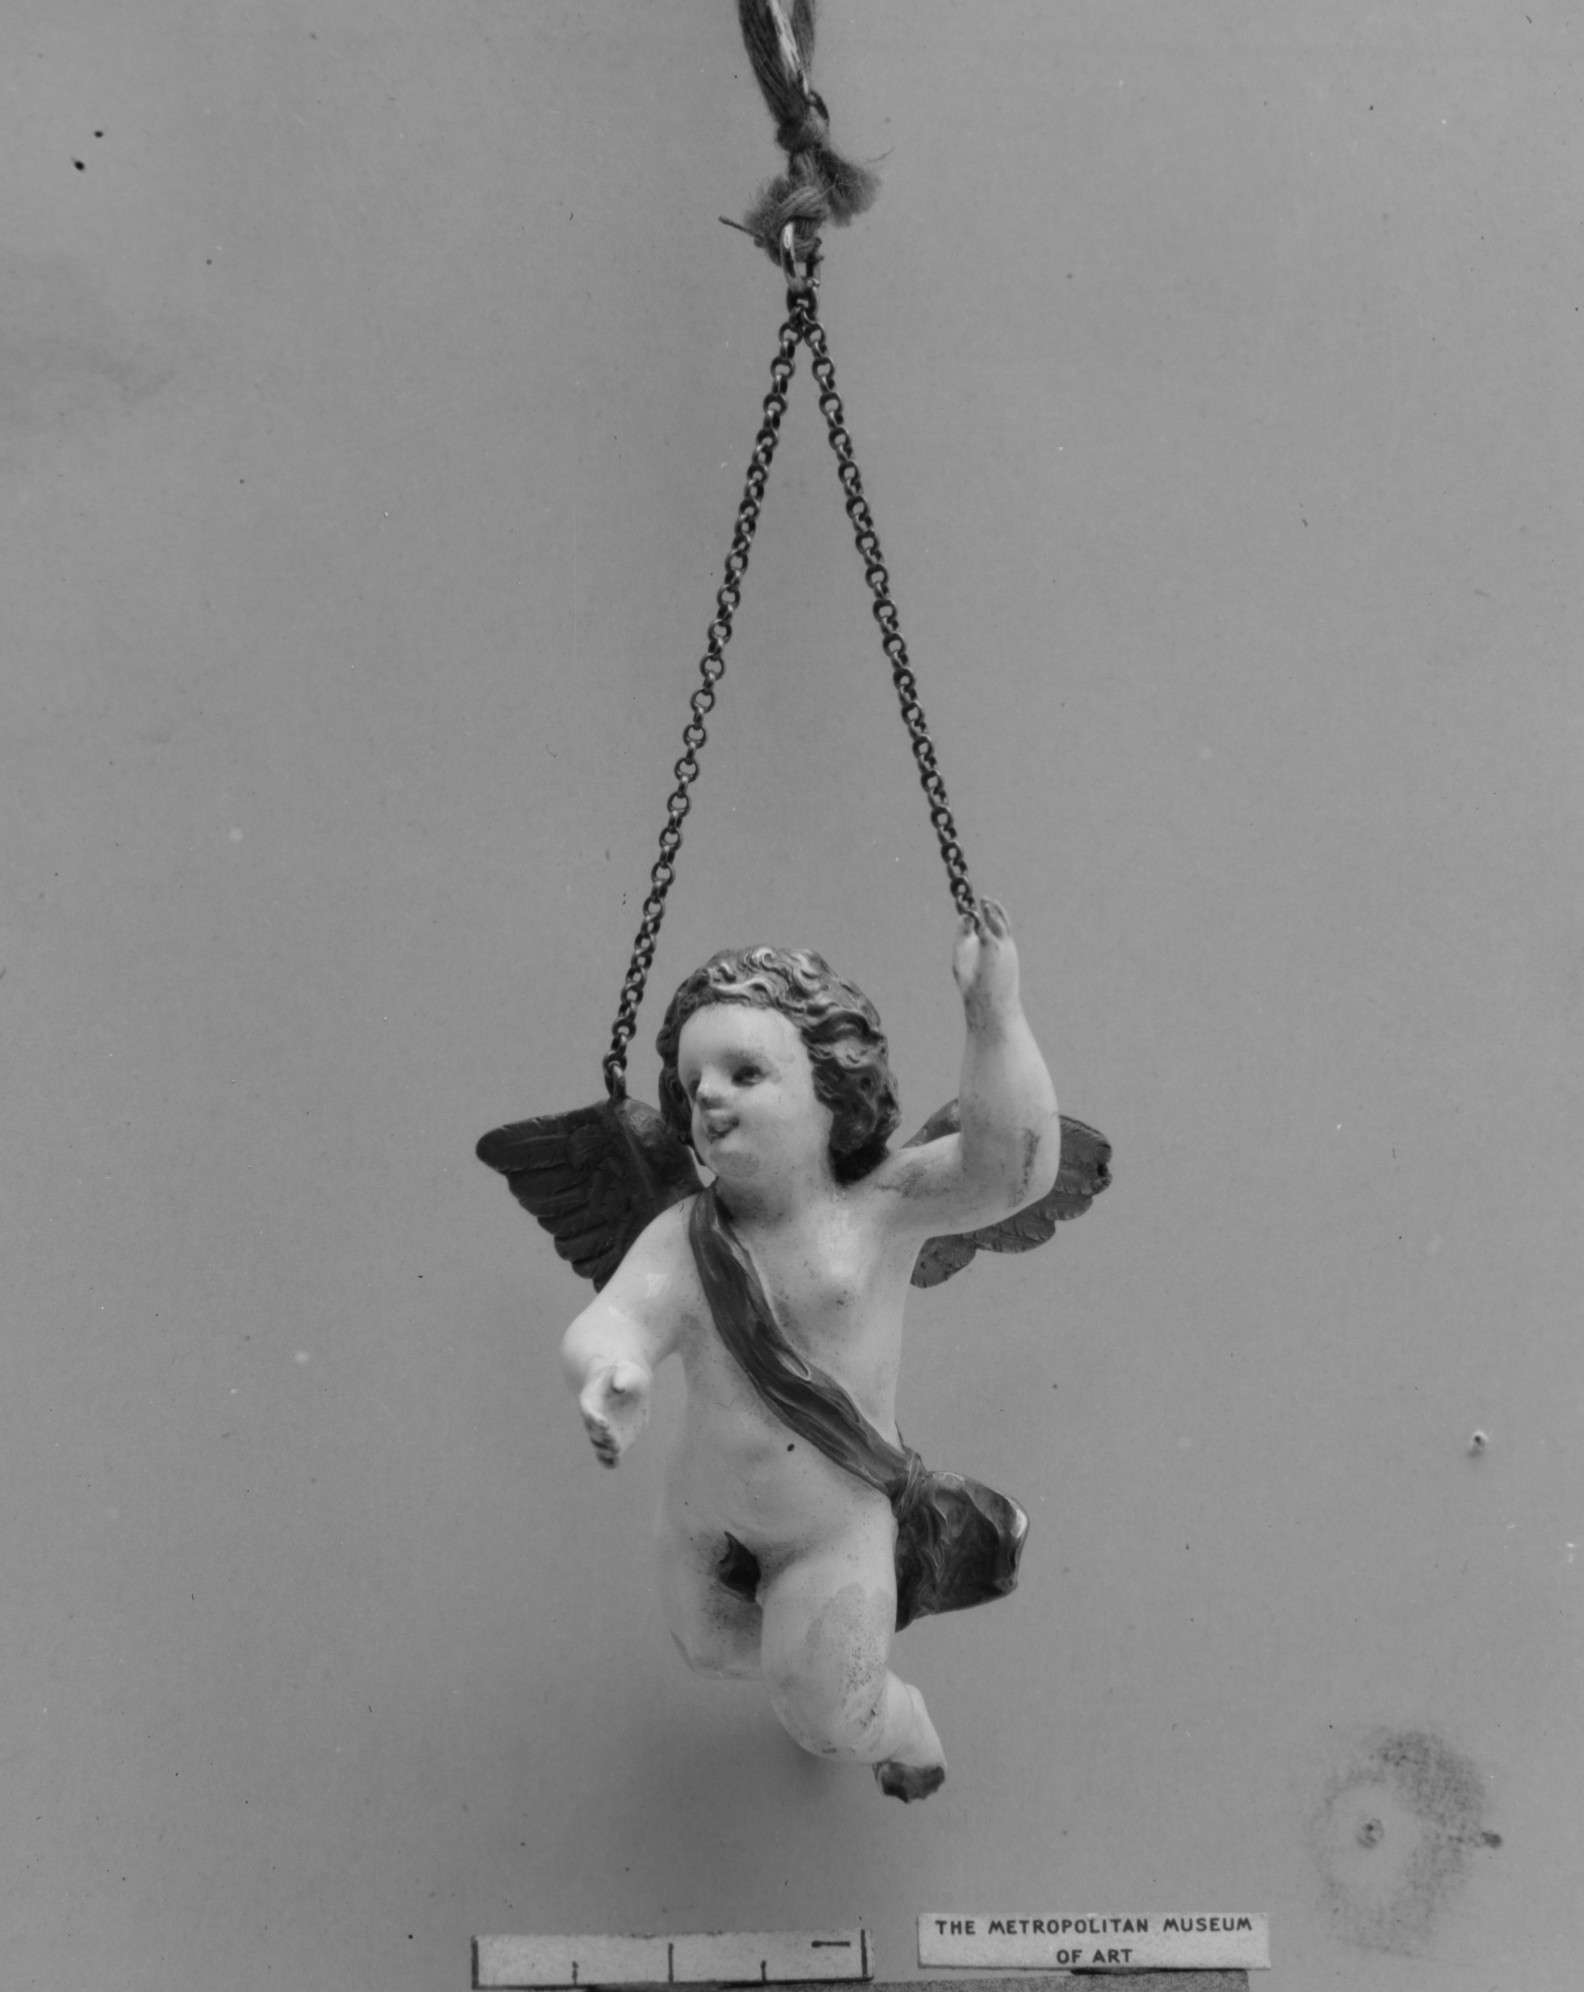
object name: pendant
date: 1601-1800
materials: enamel, gold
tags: male nudes